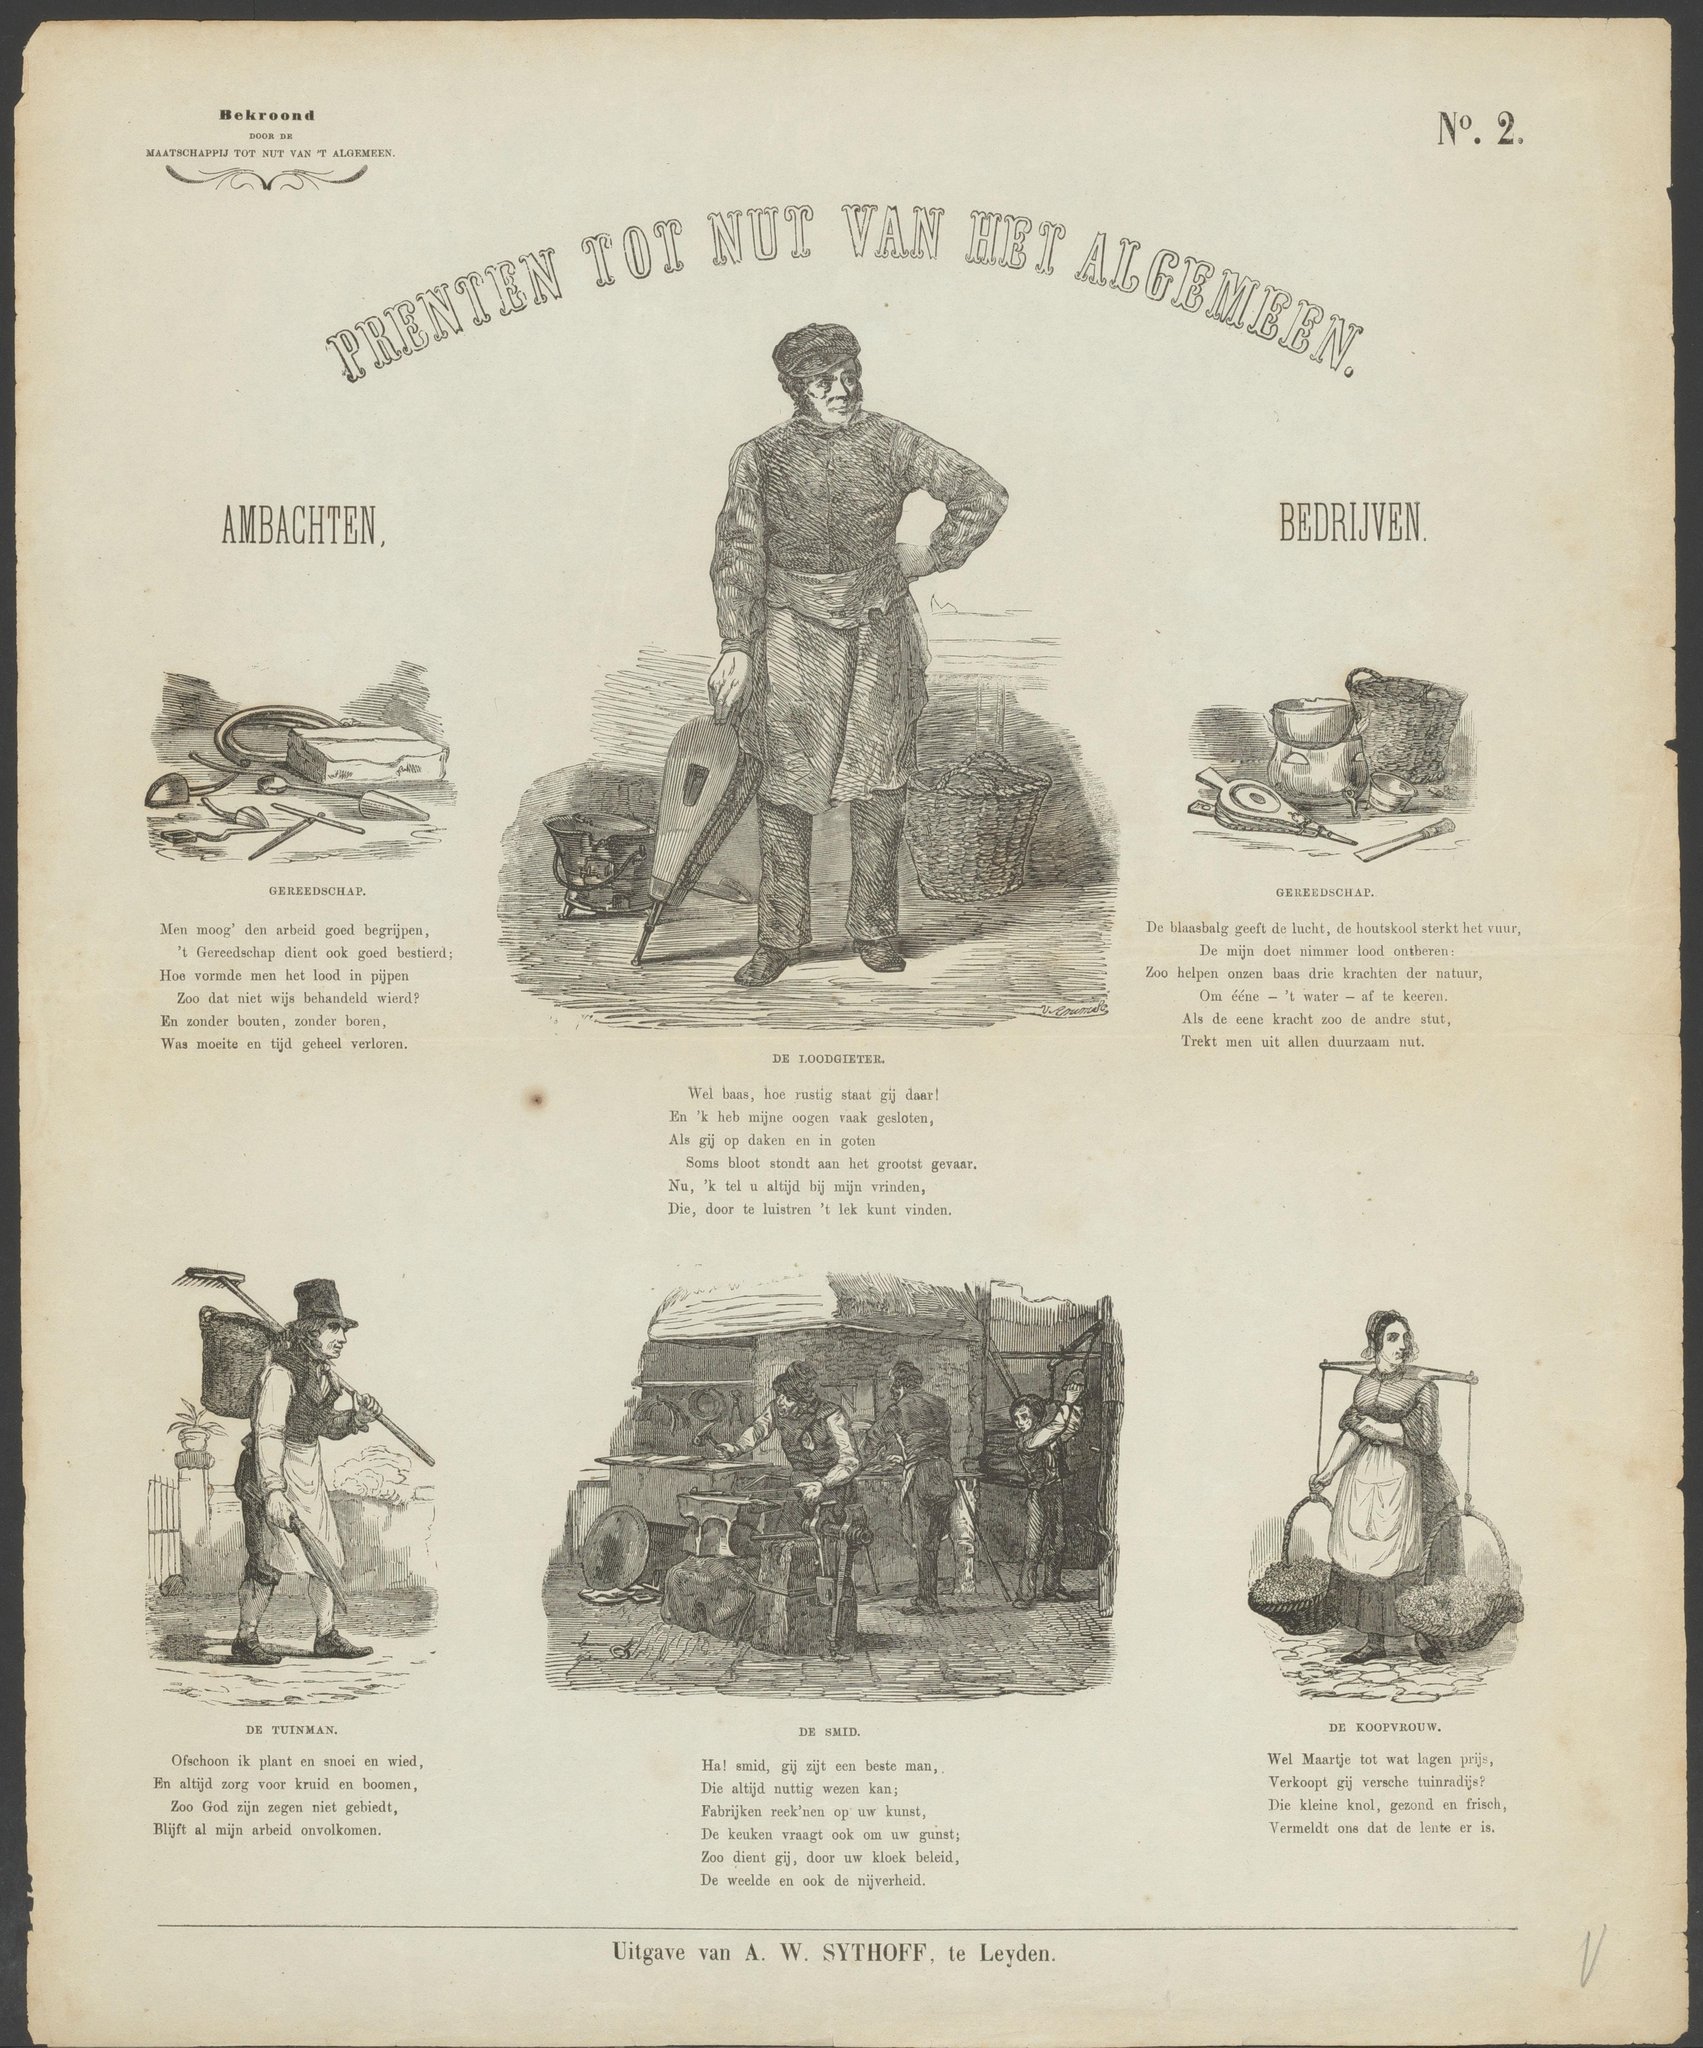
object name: print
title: Ambachten en bedrijven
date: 1851-1929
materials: paper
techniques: letterpress printing, engraving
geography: leiden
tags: tools, aids, implements ~ crafts and industries, plumber, street-trader, smith, blacksmith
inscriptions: collector's mark: Lugt 1641, stamp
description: Blad met zes voorstellingen van gereedschap, een loodgieter, een tuinman, een smid en een koopvrouw. Onder elke voorstelling een titel en een vers. Genummerd rechtsboven: No. 2. Linksboven: Bekroond door de Maatschappij tot Nut van 't Algemeen. Onderwerpsrubrieken binnen de Atlas Zeden en Gewoonten: Zeden en Gewoonten in Engeren Zin, Des menschen beging, midden en einde, Kinderleven – Kinderspel en Kinderprenten.